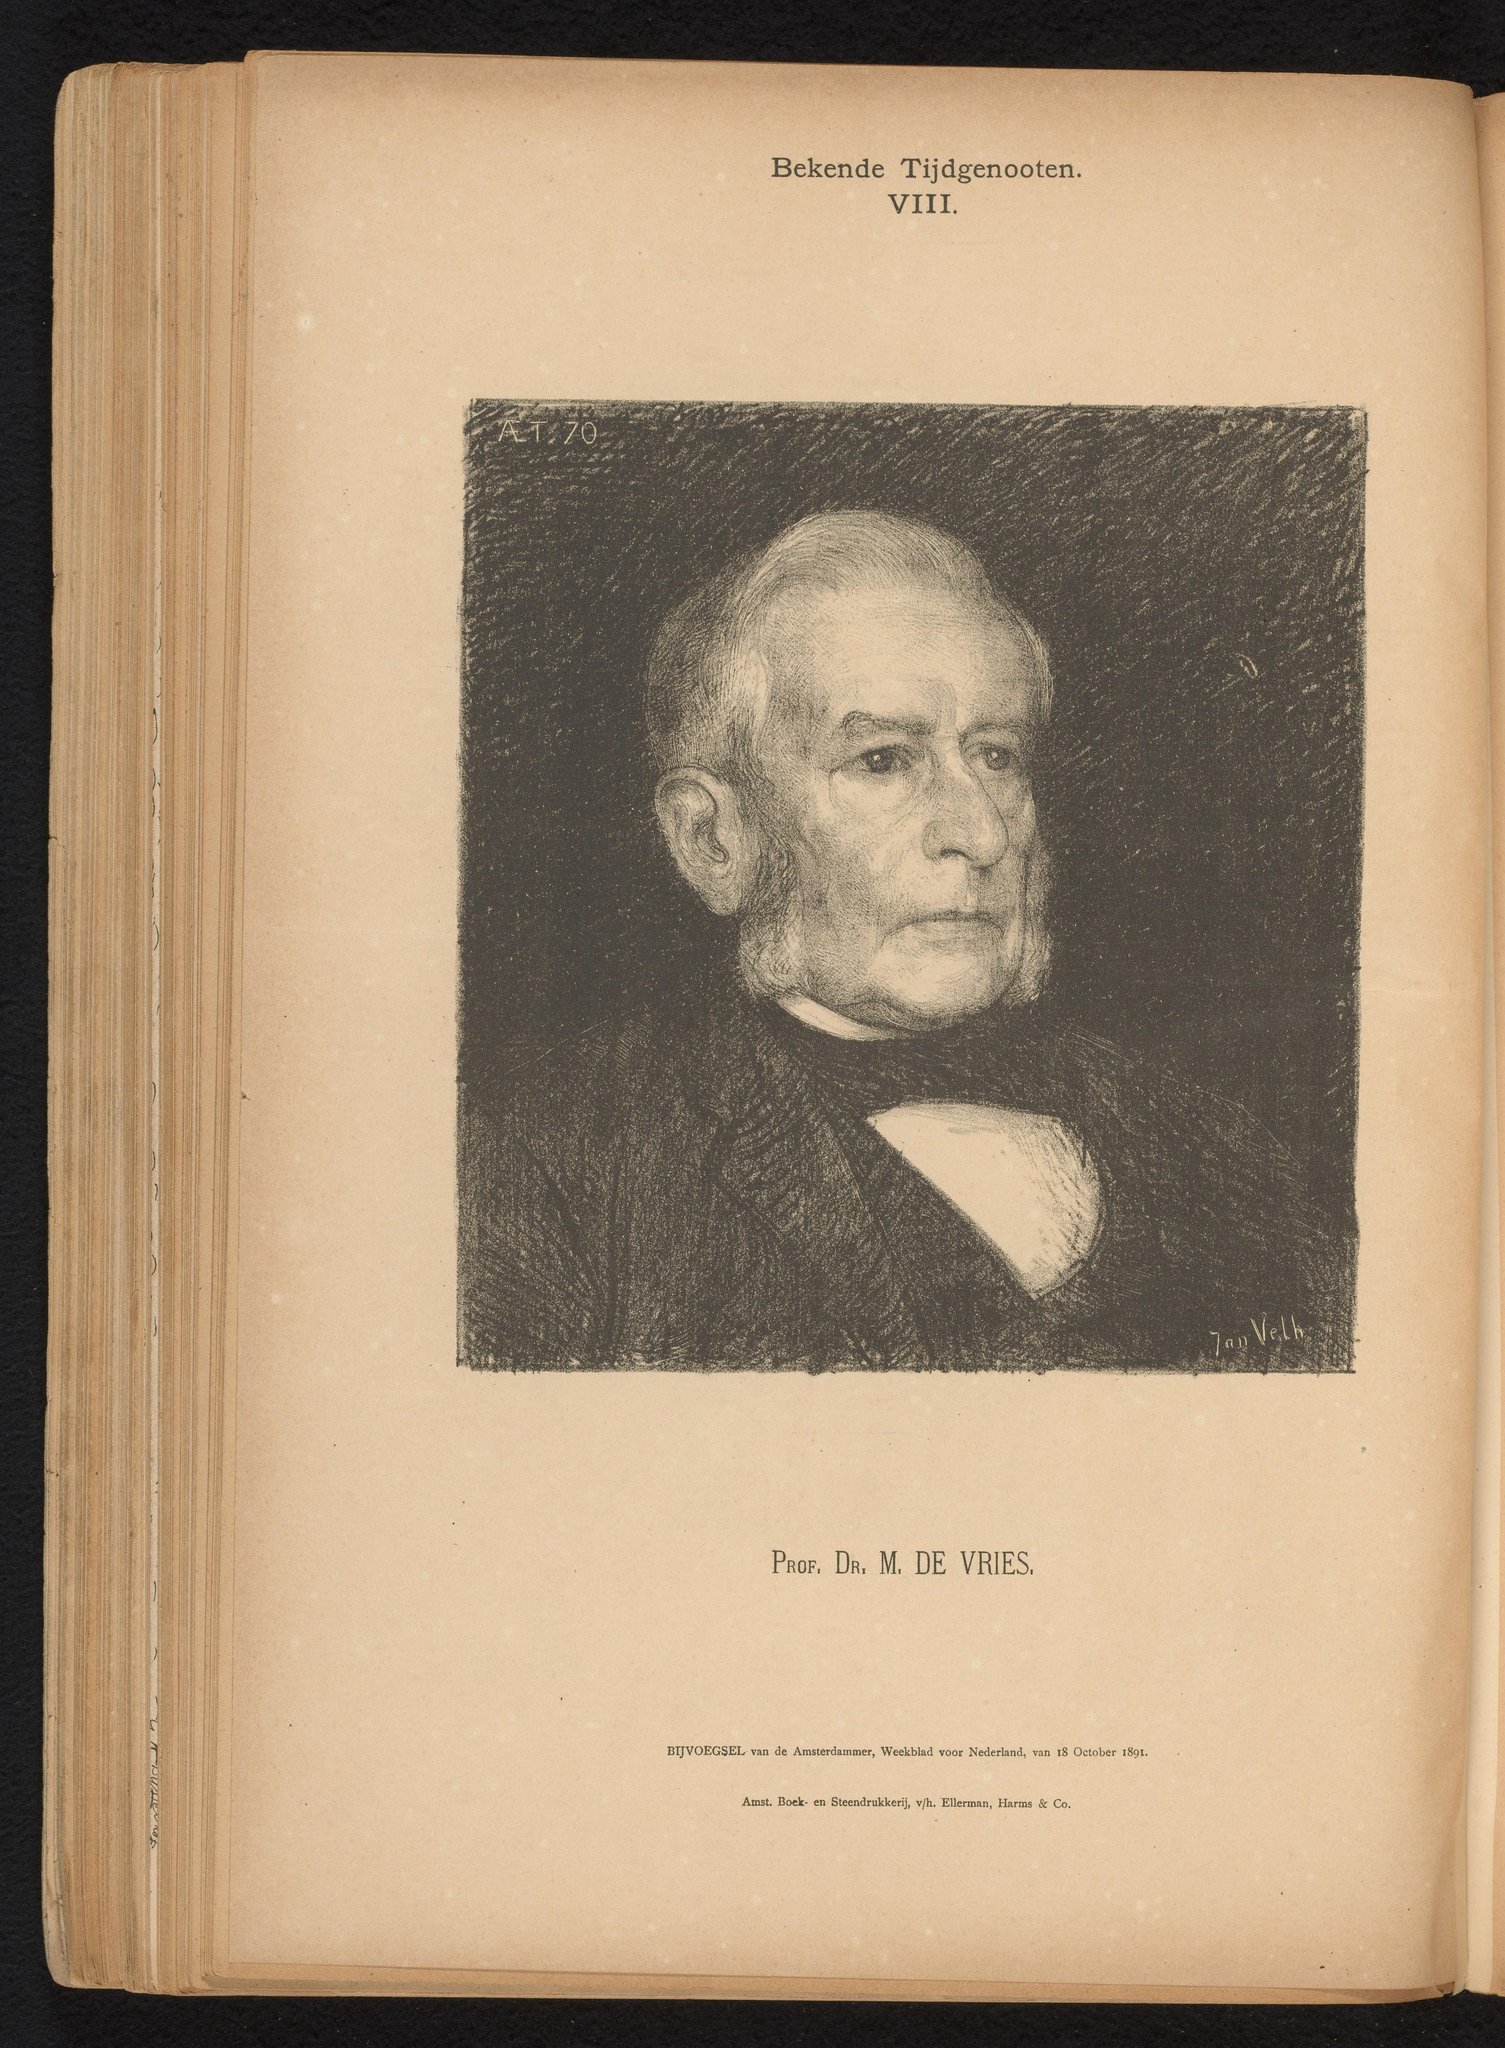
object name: print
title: Bekende Tijdgenooten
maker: jan veth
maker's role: designer, draughtsman, painter, print maker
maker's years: 1864-1925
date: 1891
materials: paper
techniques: lithograph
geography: netherlands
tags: haarlem, leiden, historical persons, professor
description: Portret van Matthias de Vries, hoogleraar wijsbegeerte en letteren aan de Universiteit van Leiden. In de serie 'Bekende Tijdgenooten', nr. VIII.